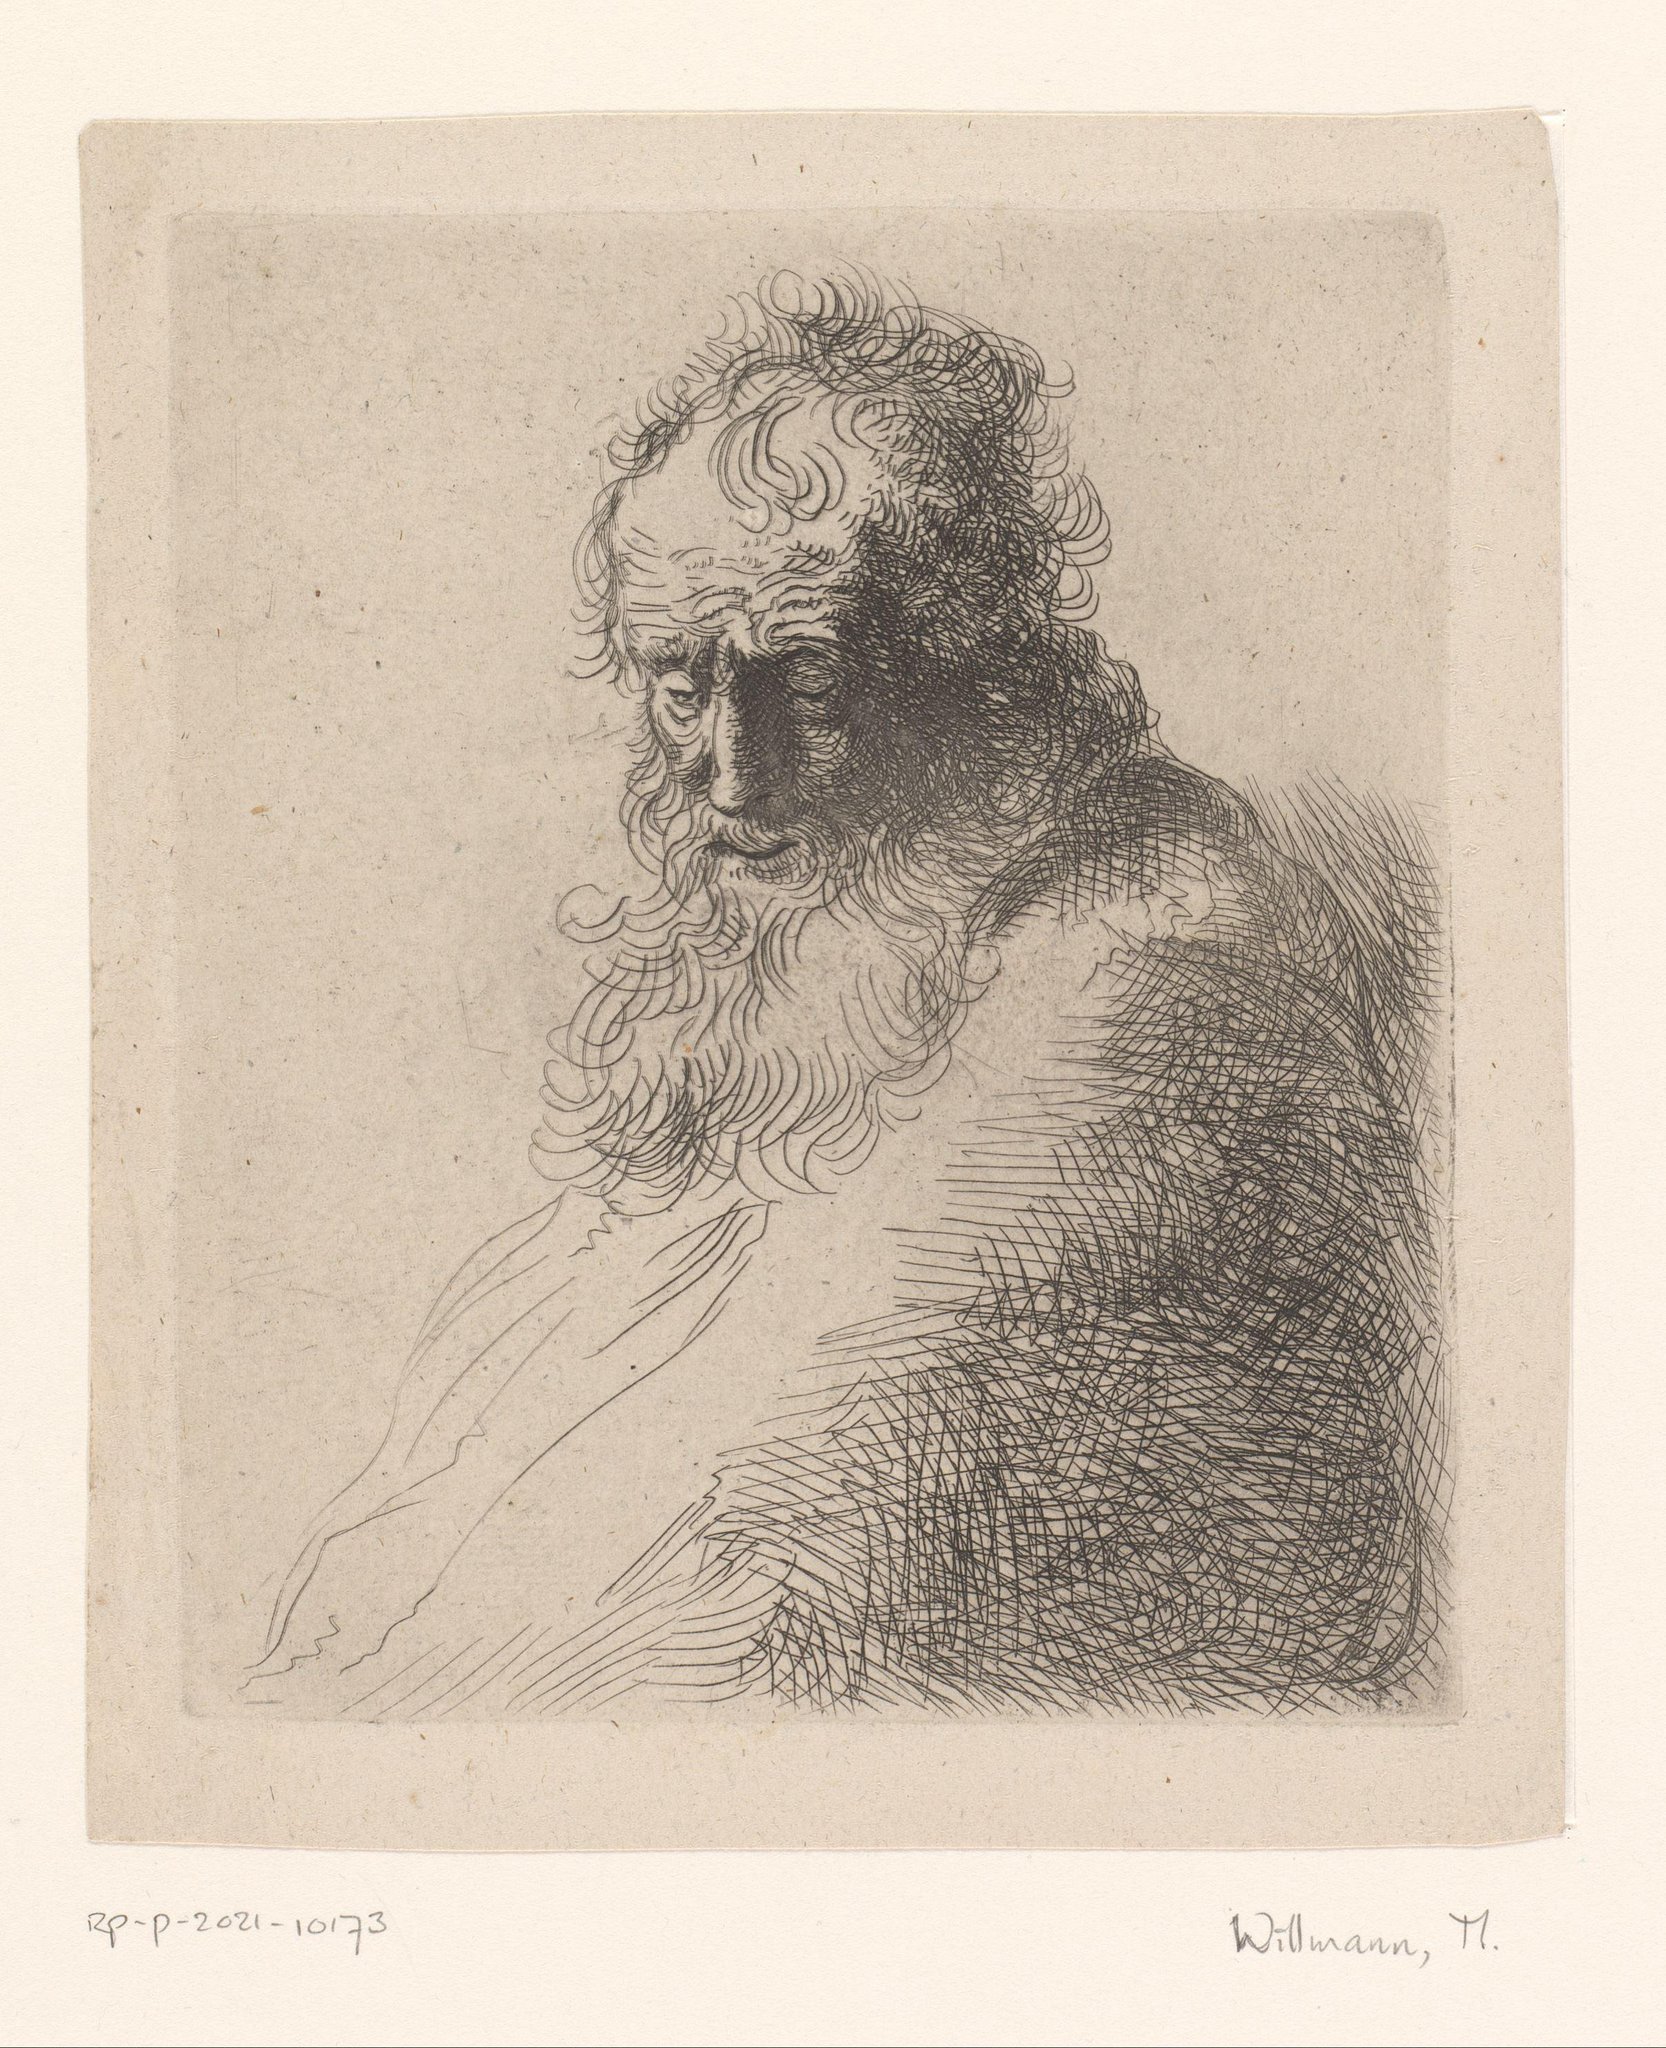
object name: print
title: Bust of an old bearded man, looking down, three quarters right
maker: michael willmann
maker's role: draughtsman, print maker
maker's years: 1630-1706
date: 1640-1706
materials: paper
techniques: etching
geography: germany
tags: old man, eyes closed, beard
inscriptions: collector's mark: Lugt 2028, inscription: ‘wordt toegeschreven aan Salomon Koninck’